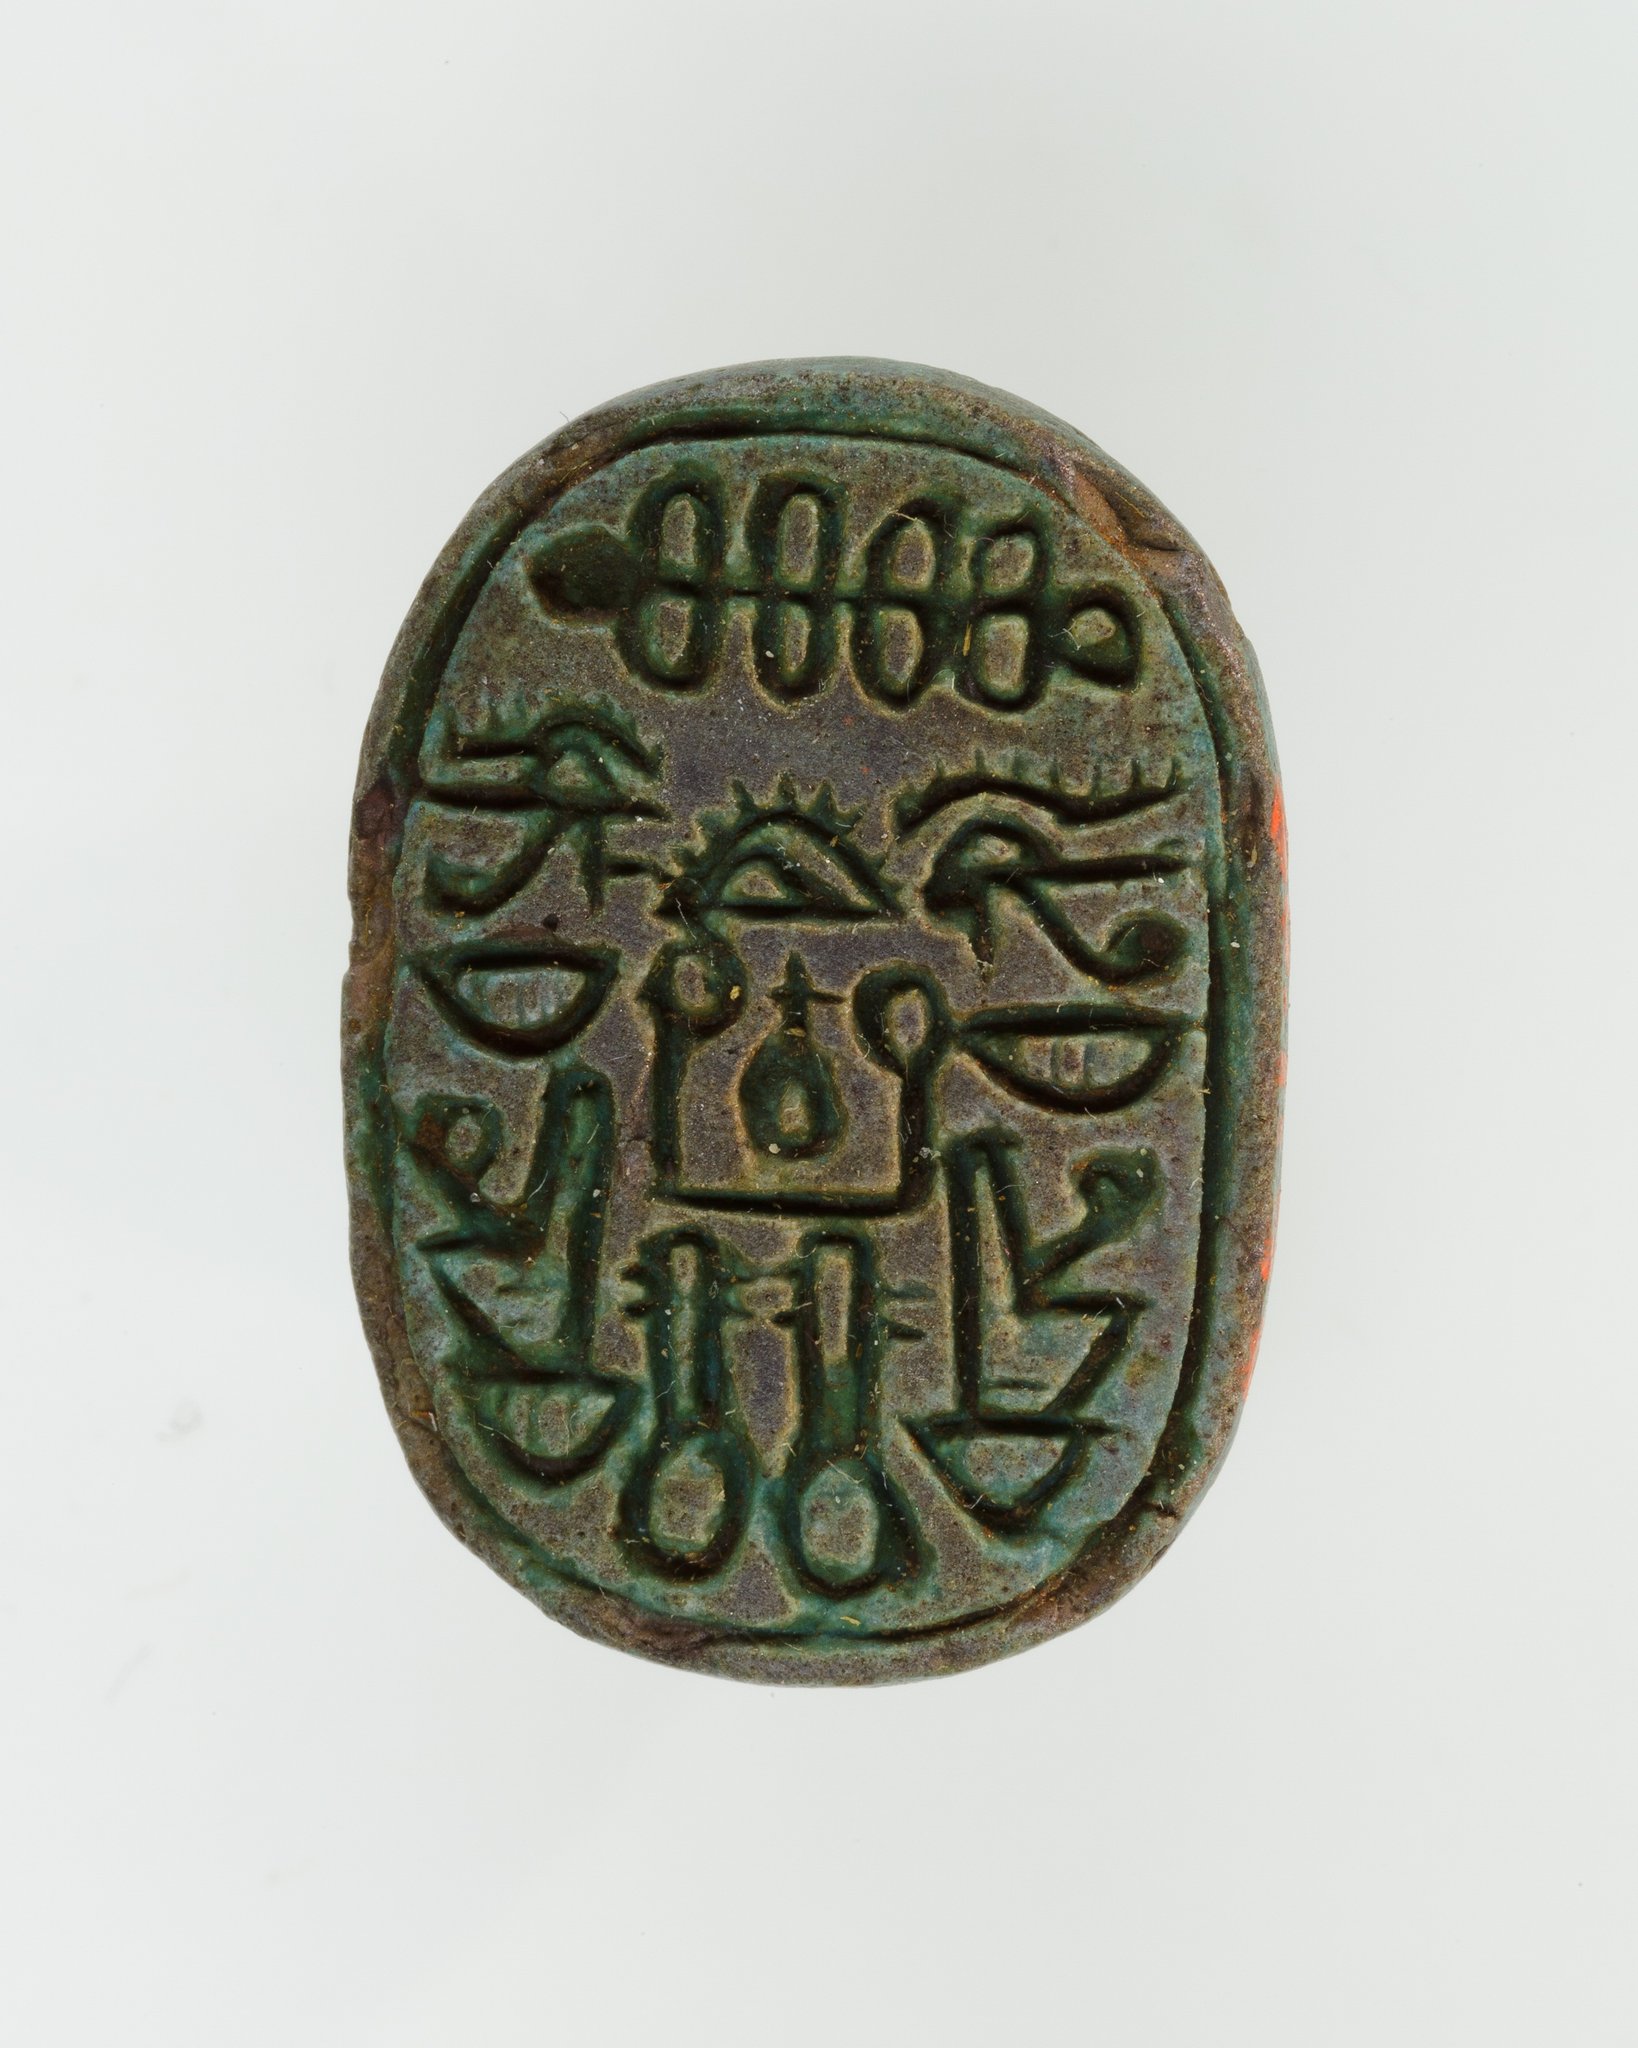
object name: scarab, red crown, sa hieroglyph, neb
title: Scarab Inscribed with Hieroglyphs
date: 1850-1640 BCE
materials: faience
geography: egypt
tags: hieroglyphs,scarabs